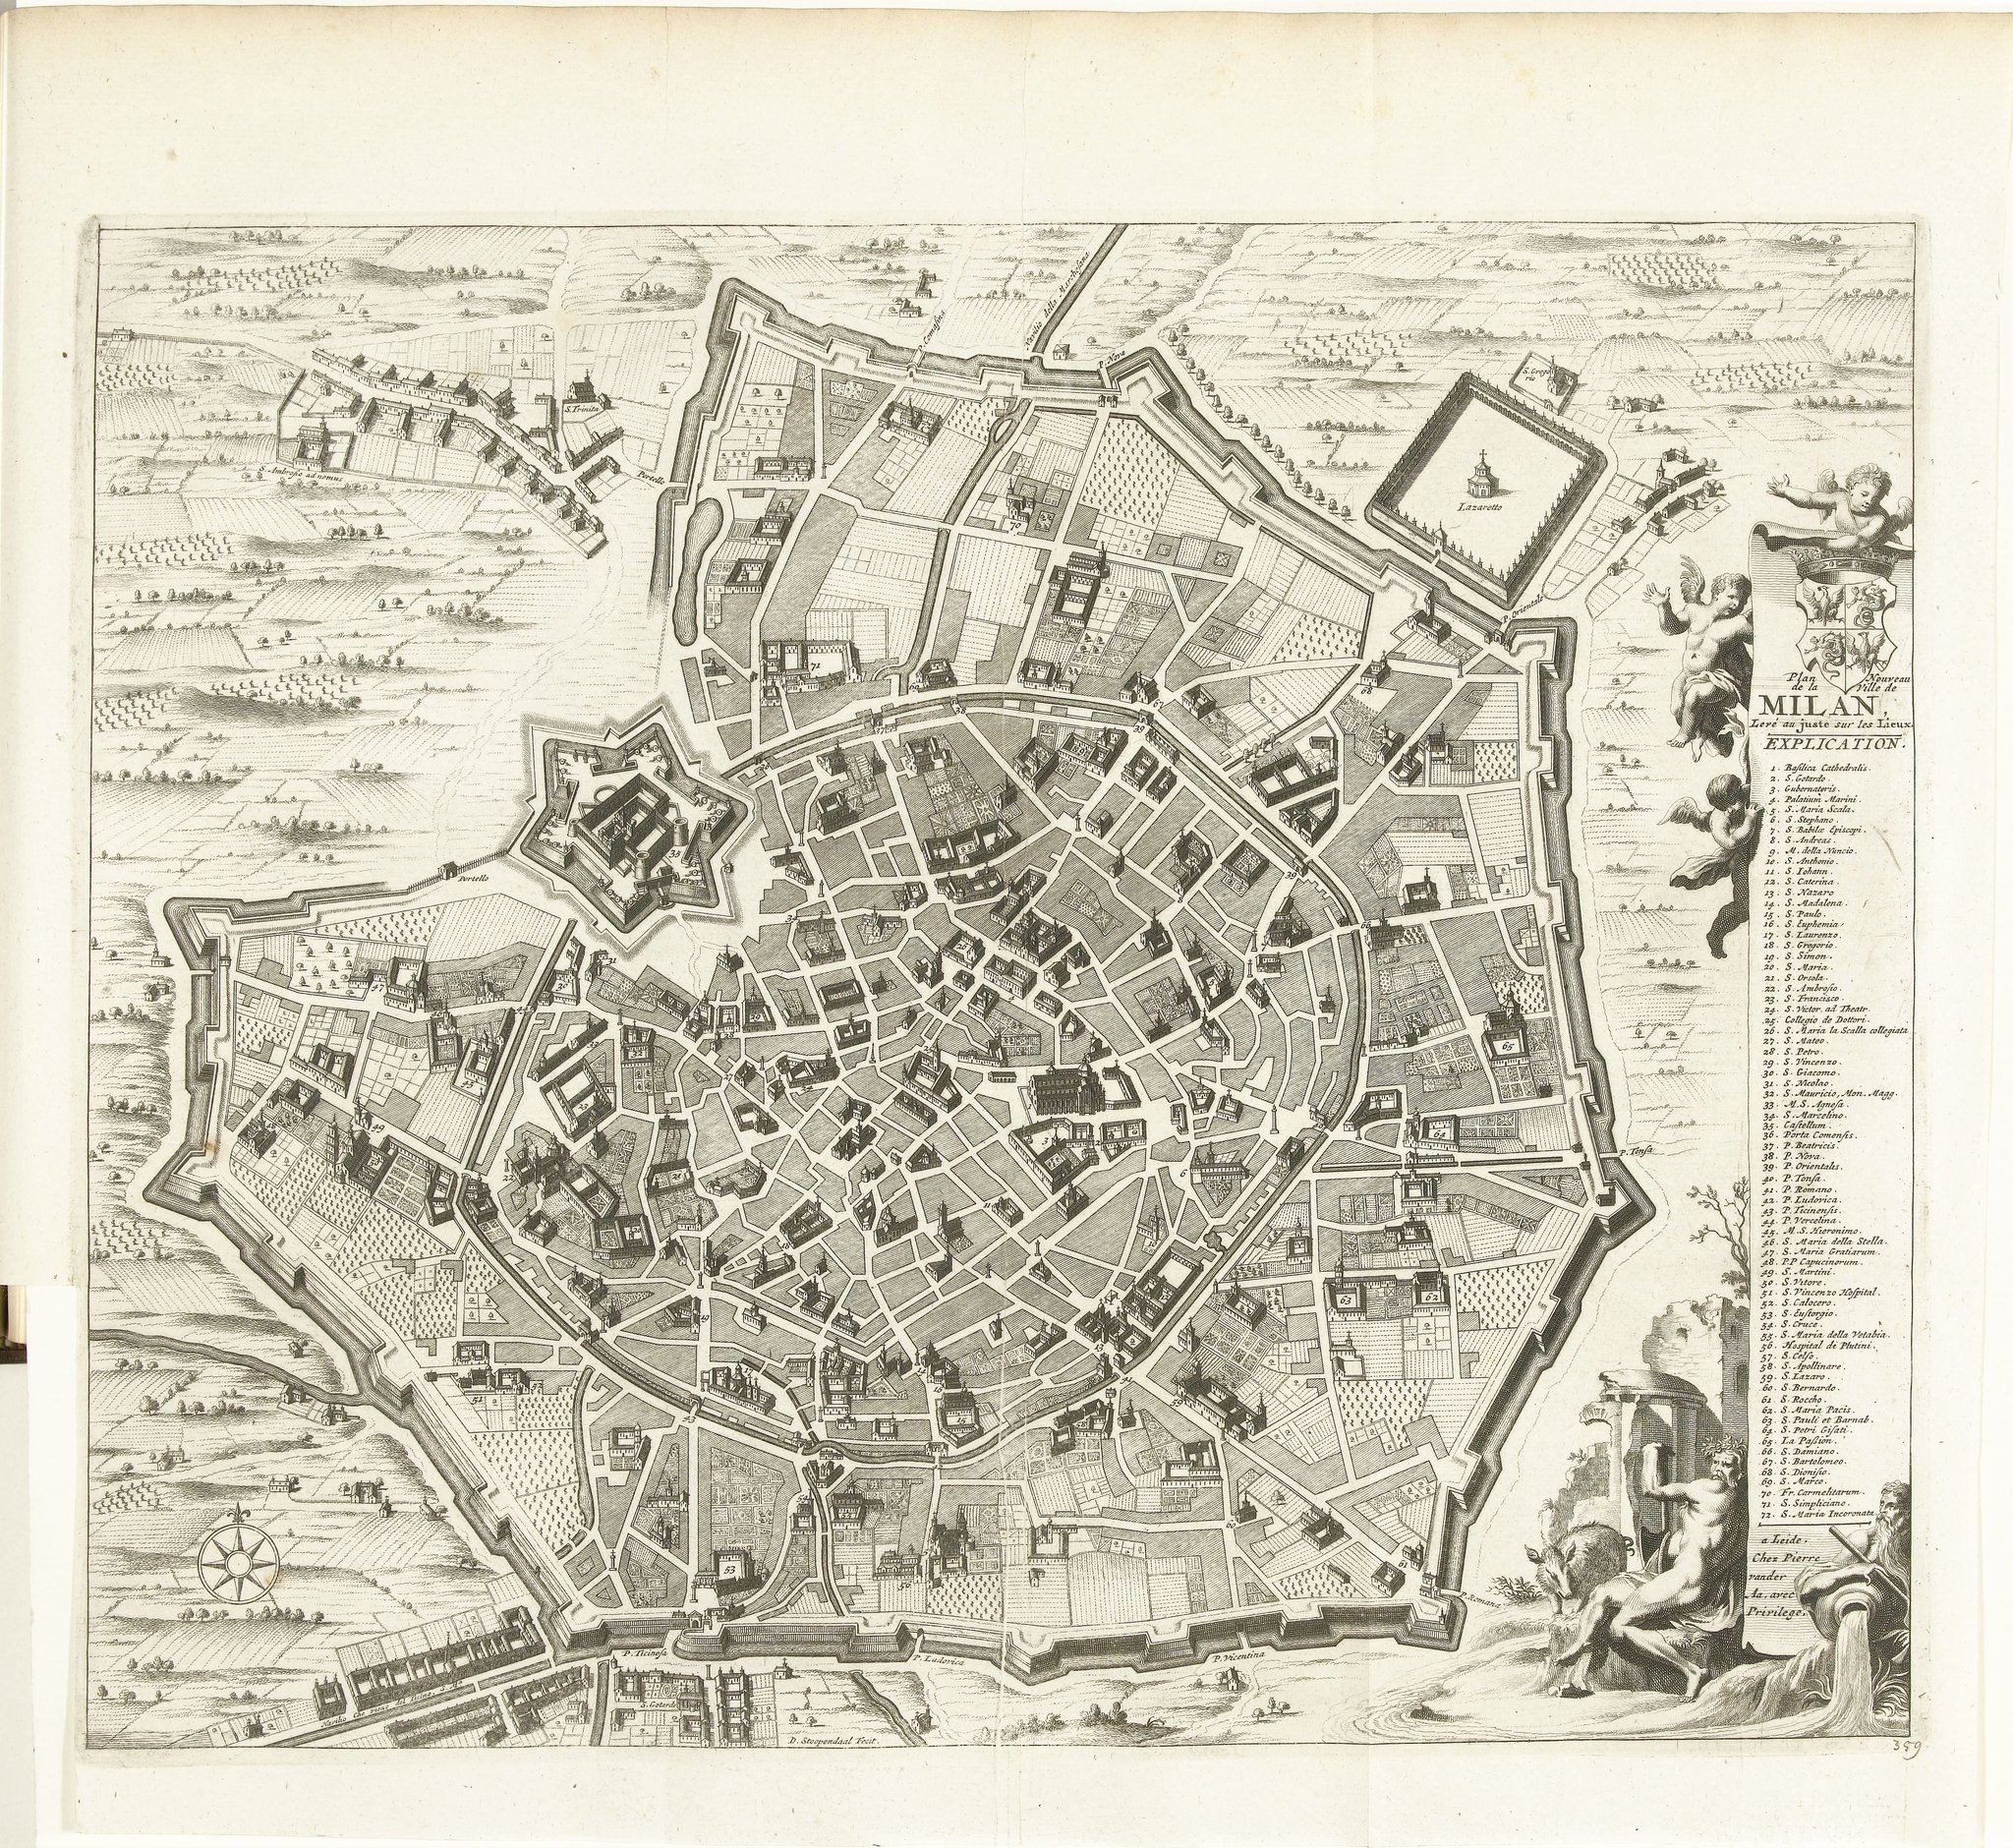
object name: print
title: Les Forces de l'Europe, Asie, Afrique et Amerique (...) Comme aussi les Cartes des Côtes de France et d'Espagne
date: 1726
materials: paper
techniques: etching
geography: northern netherlands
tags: maps of cities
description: Plattegrond van de Italiaanse stad Milaan. Plaat nr. 359 in deel XV van het prentwerk: Les Forces de l'Europe, Asie, Afrique et Amerique ... Comme aussi les Cartes des Côtes de France et d'Espagne uit 1726, dit tweede deel met 271 met de hand genummerde platen van vermaarde sterke steden en vestingen in het kader van de Spaanse Successieoorlog 1701-1713. Voor het merendeel zijn deze platen gekopieerd naar de anonieme Franse platen van vermaarde sterke steden en vestingen: in Les forces de l'Europe en in: Le theatre de la guerre, dans les Pays-Bas, beide oorspronkelijk uitgegeven door Nicolas de Fer te Parijs (1693-1697) in het kader van de Negenjarige Oorlog. Titel en opschriften in het Frans.